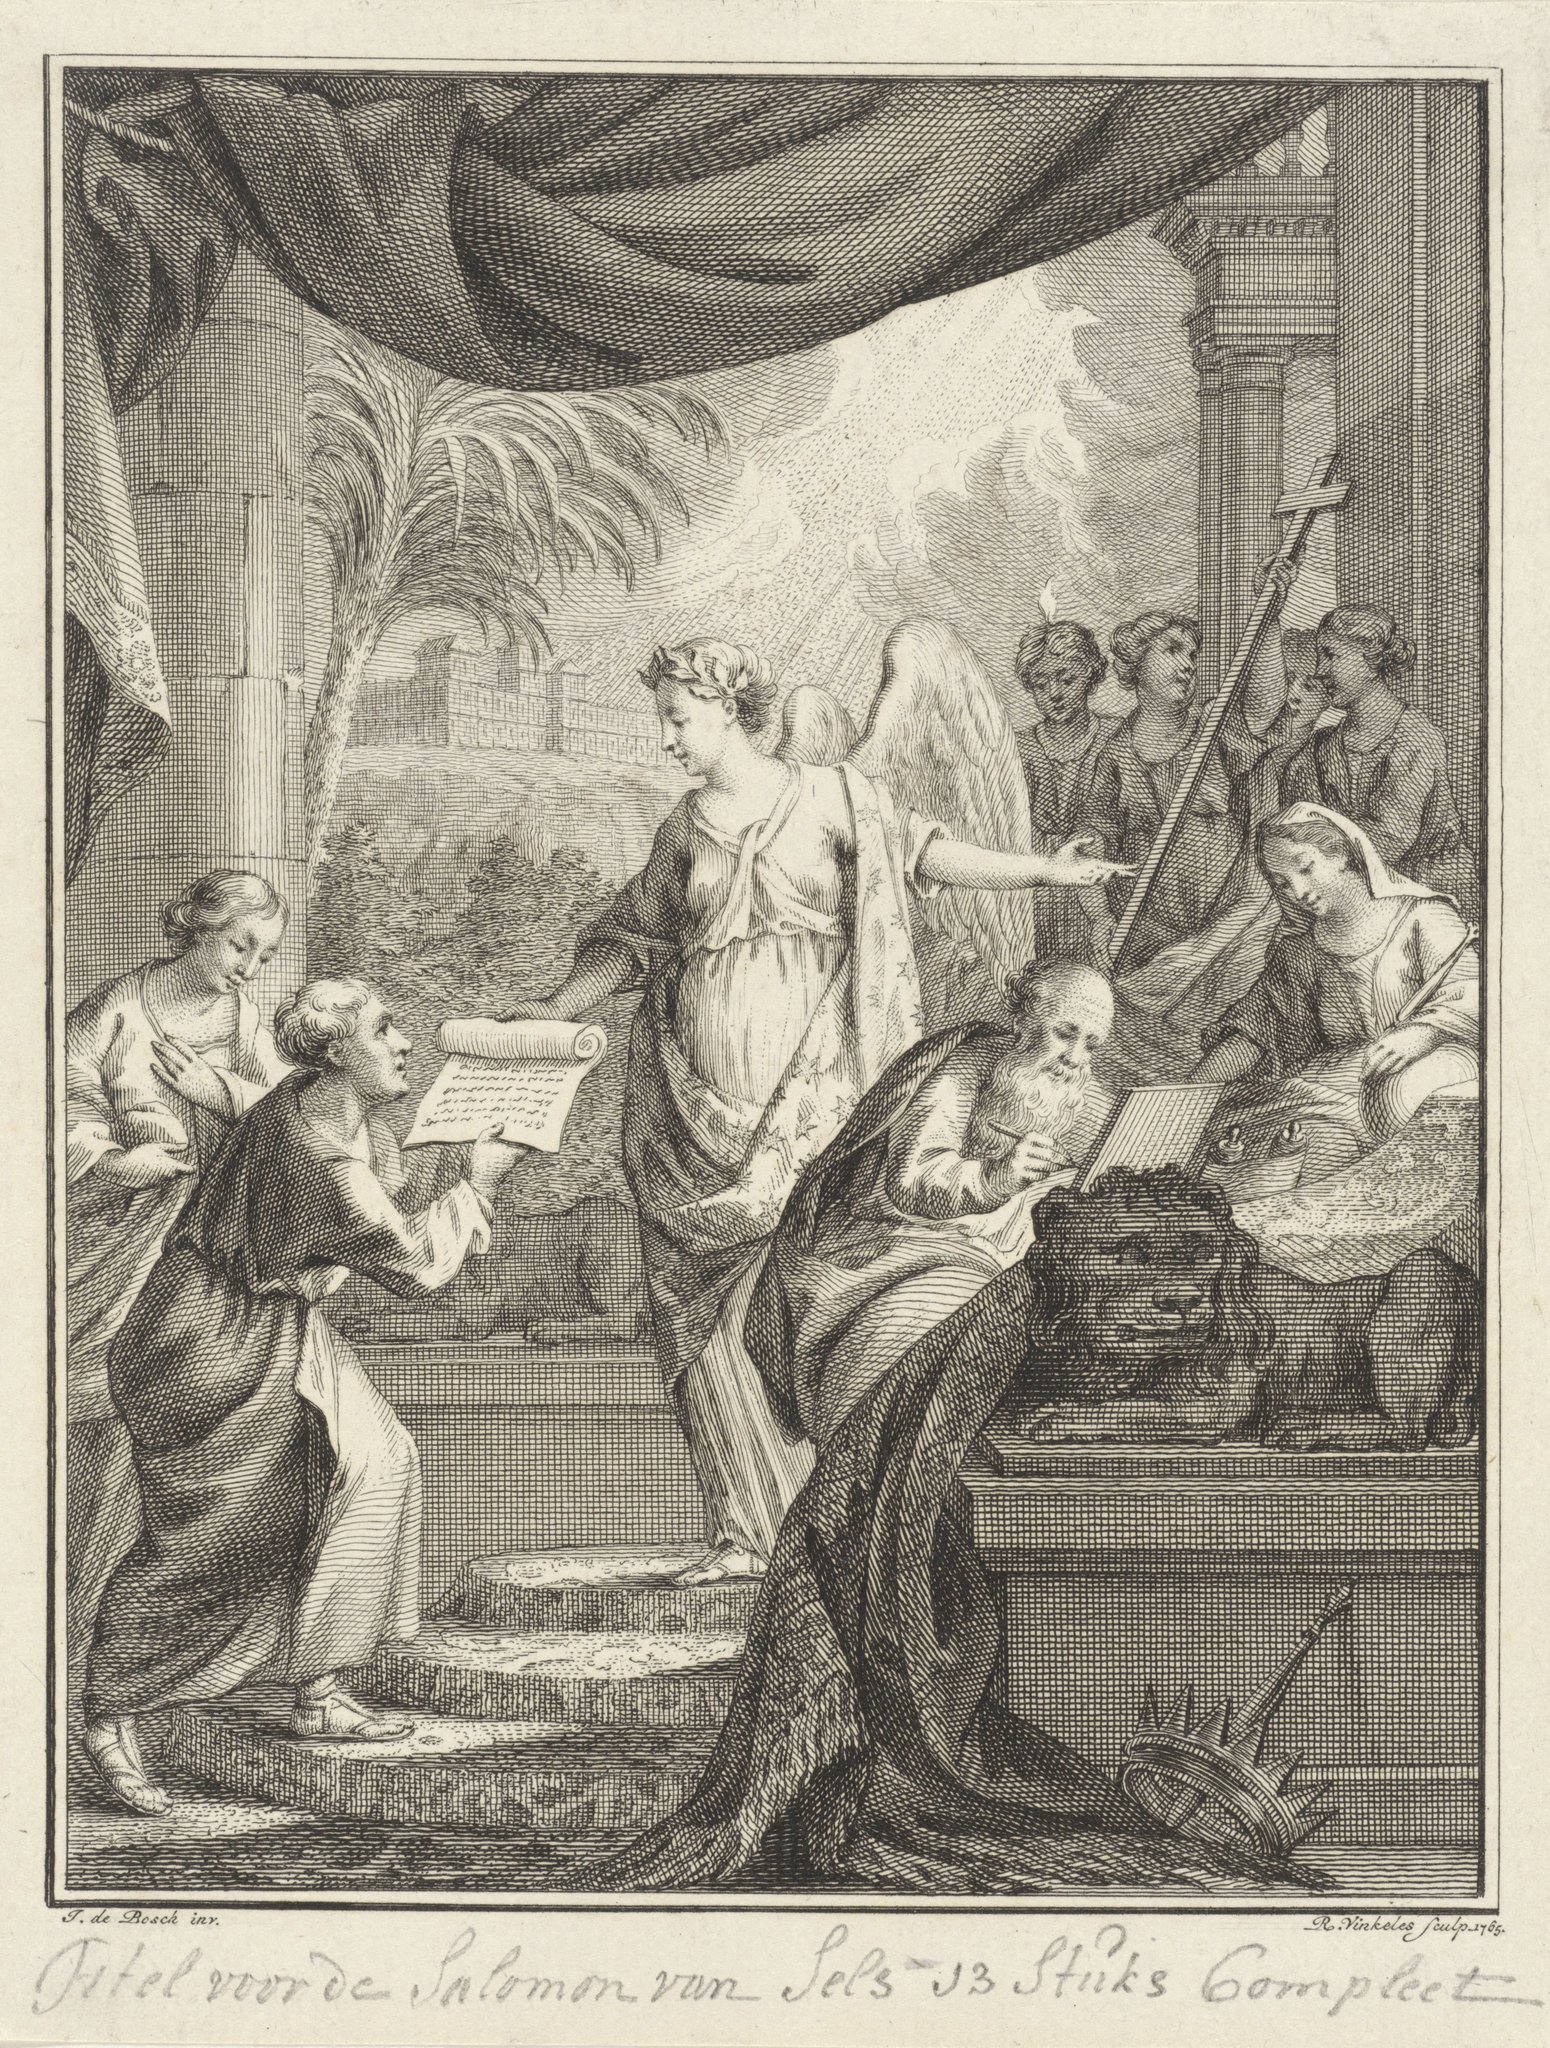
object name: print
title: Allegorische voorstelling met een engel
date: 1765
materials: paper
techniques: engraving, etching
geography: amsterdam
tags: handwriting, writing as activity, faith, 'fides'; 'fede', 'fede catholica', 'fede christiana', 'fede christiana catholica' (ripa) ~ one of the three theological virtues, beasts of prey, predatory animals: lion, angels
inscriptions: inscription: ‘Titel voor de Salomon van Sels 13 Stuks Compleet’, collector's mark: Lugt 240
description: Een engel reikt een monnik een rol papier aan. Op de voorgrond zit een oude man met een baard een boek te schrijven, naast hem een vrouw. Op de achtergrond de figuren met symbolen van het Ware Geloof.